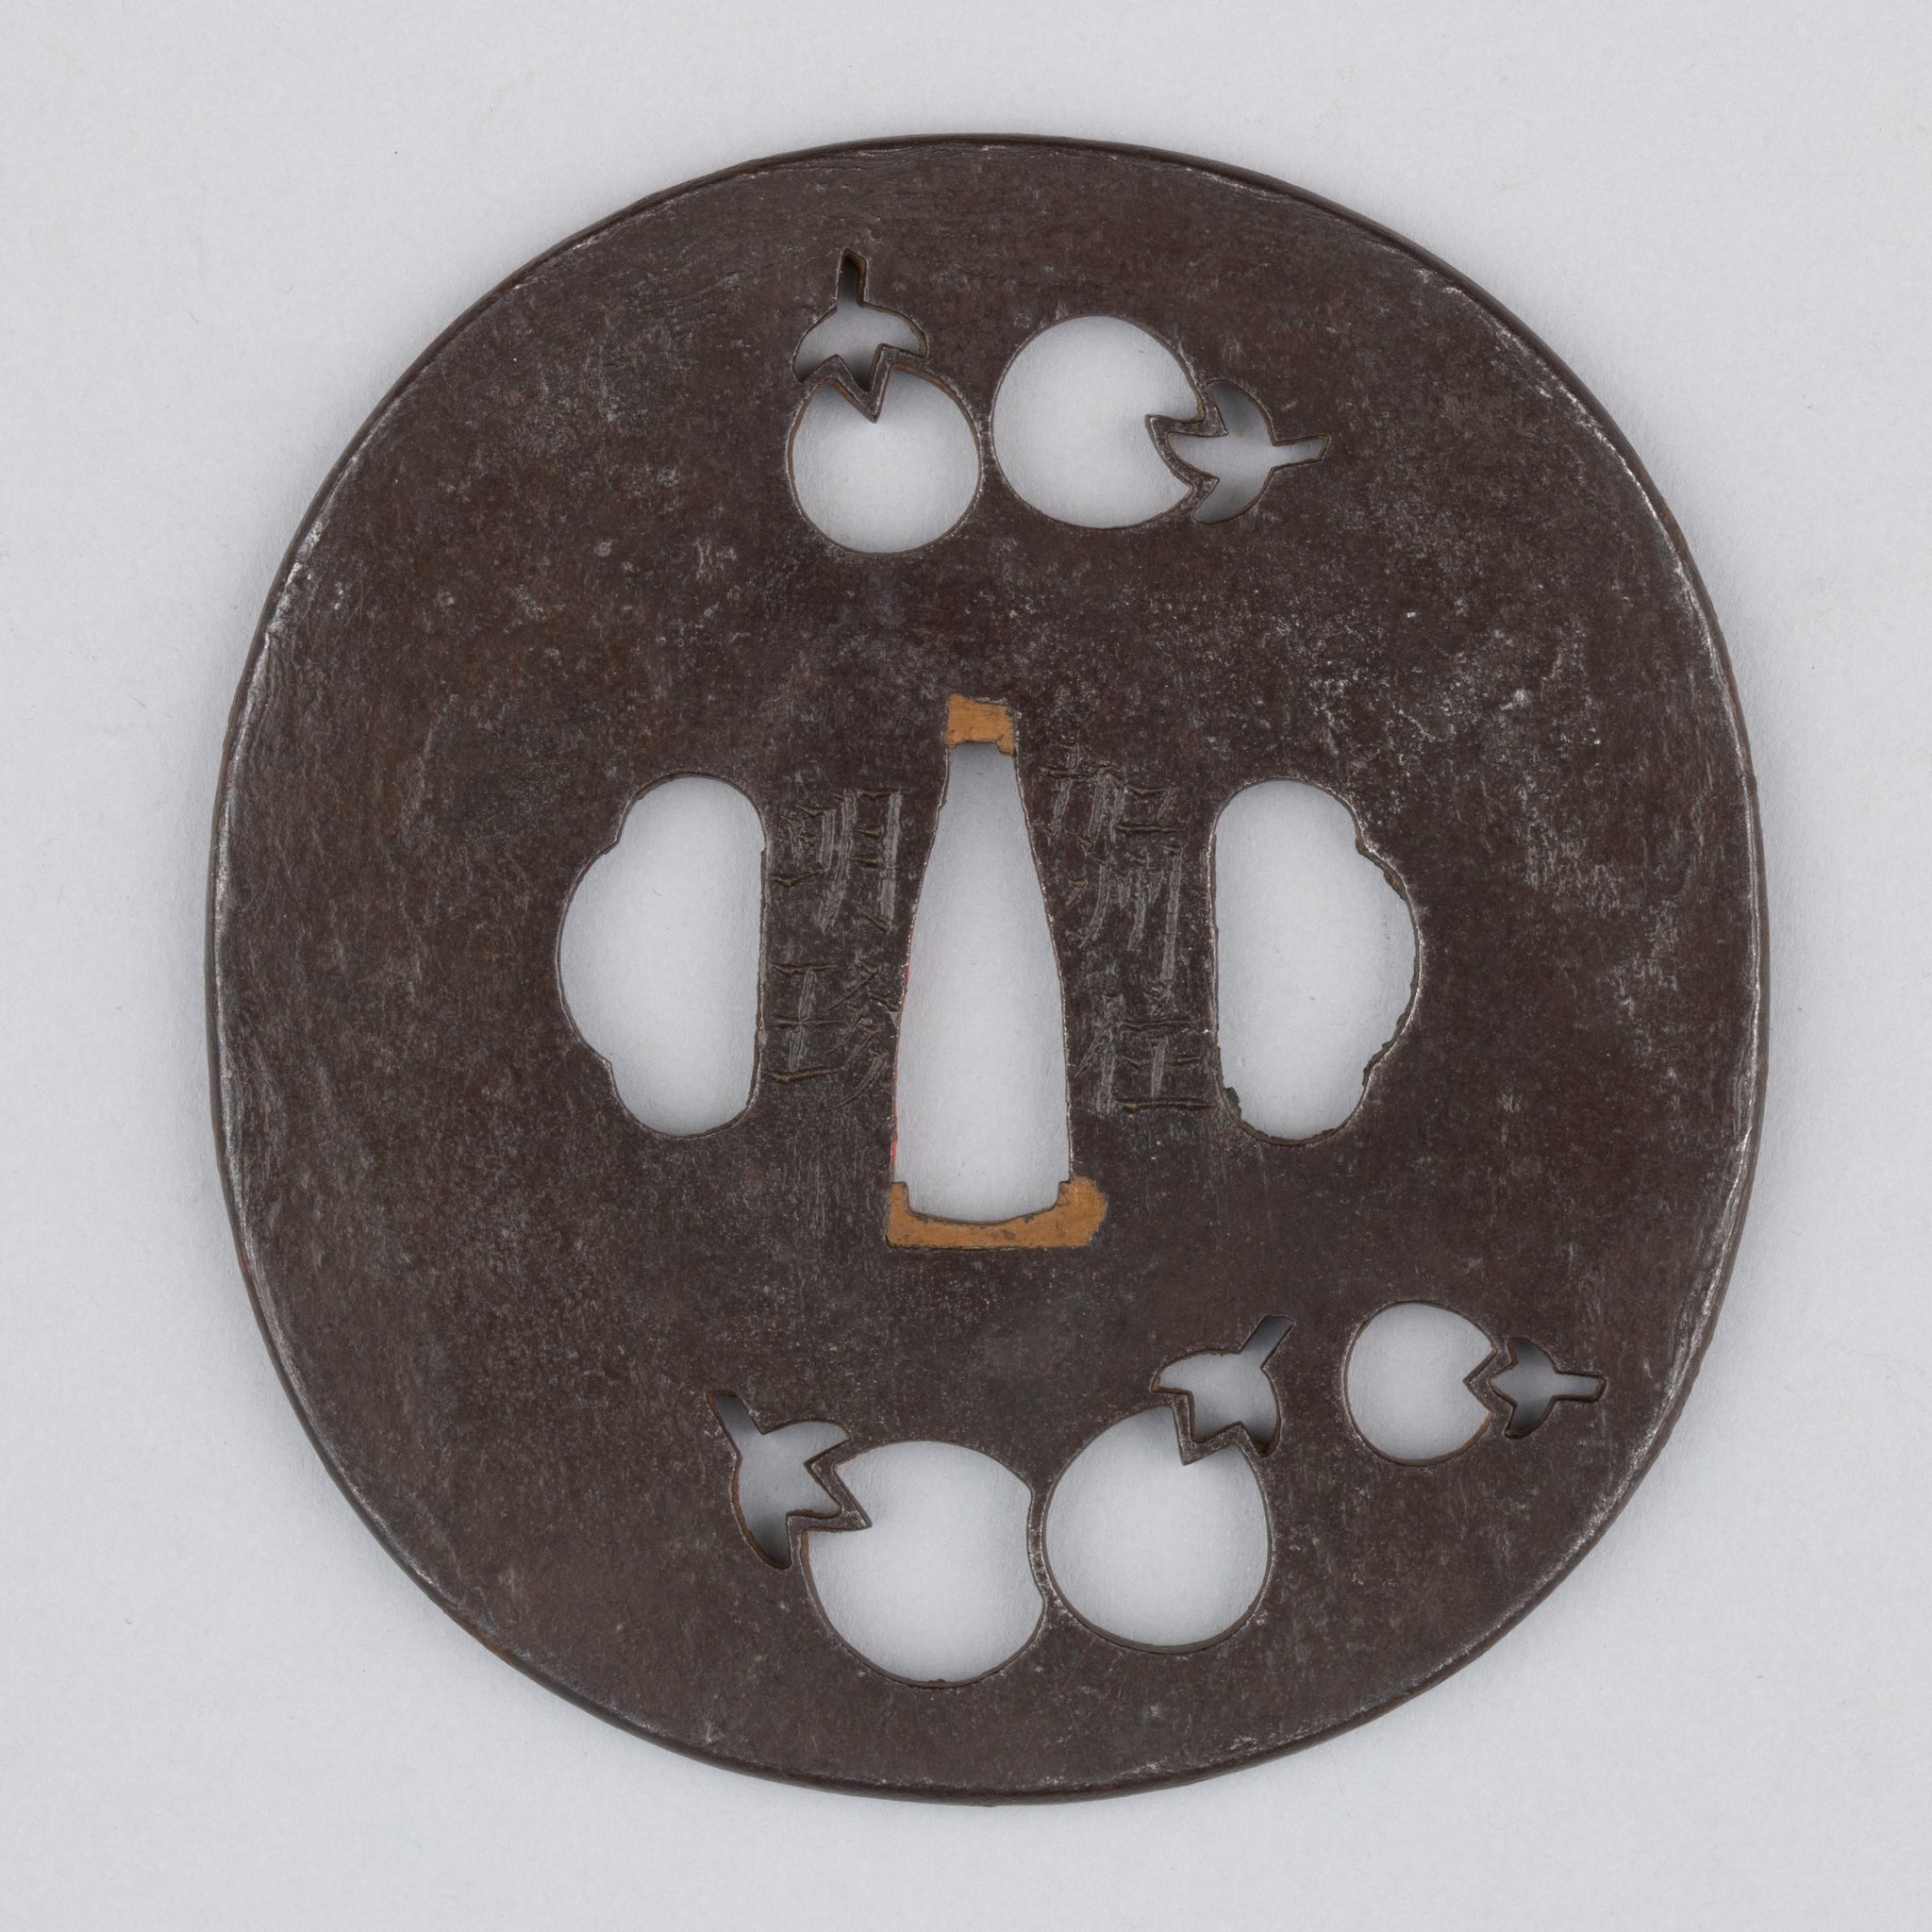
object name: sword guard tsuba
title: Sword Guard (Tsuba)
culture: japanese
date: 1701-1800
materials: copper, iron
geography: japan